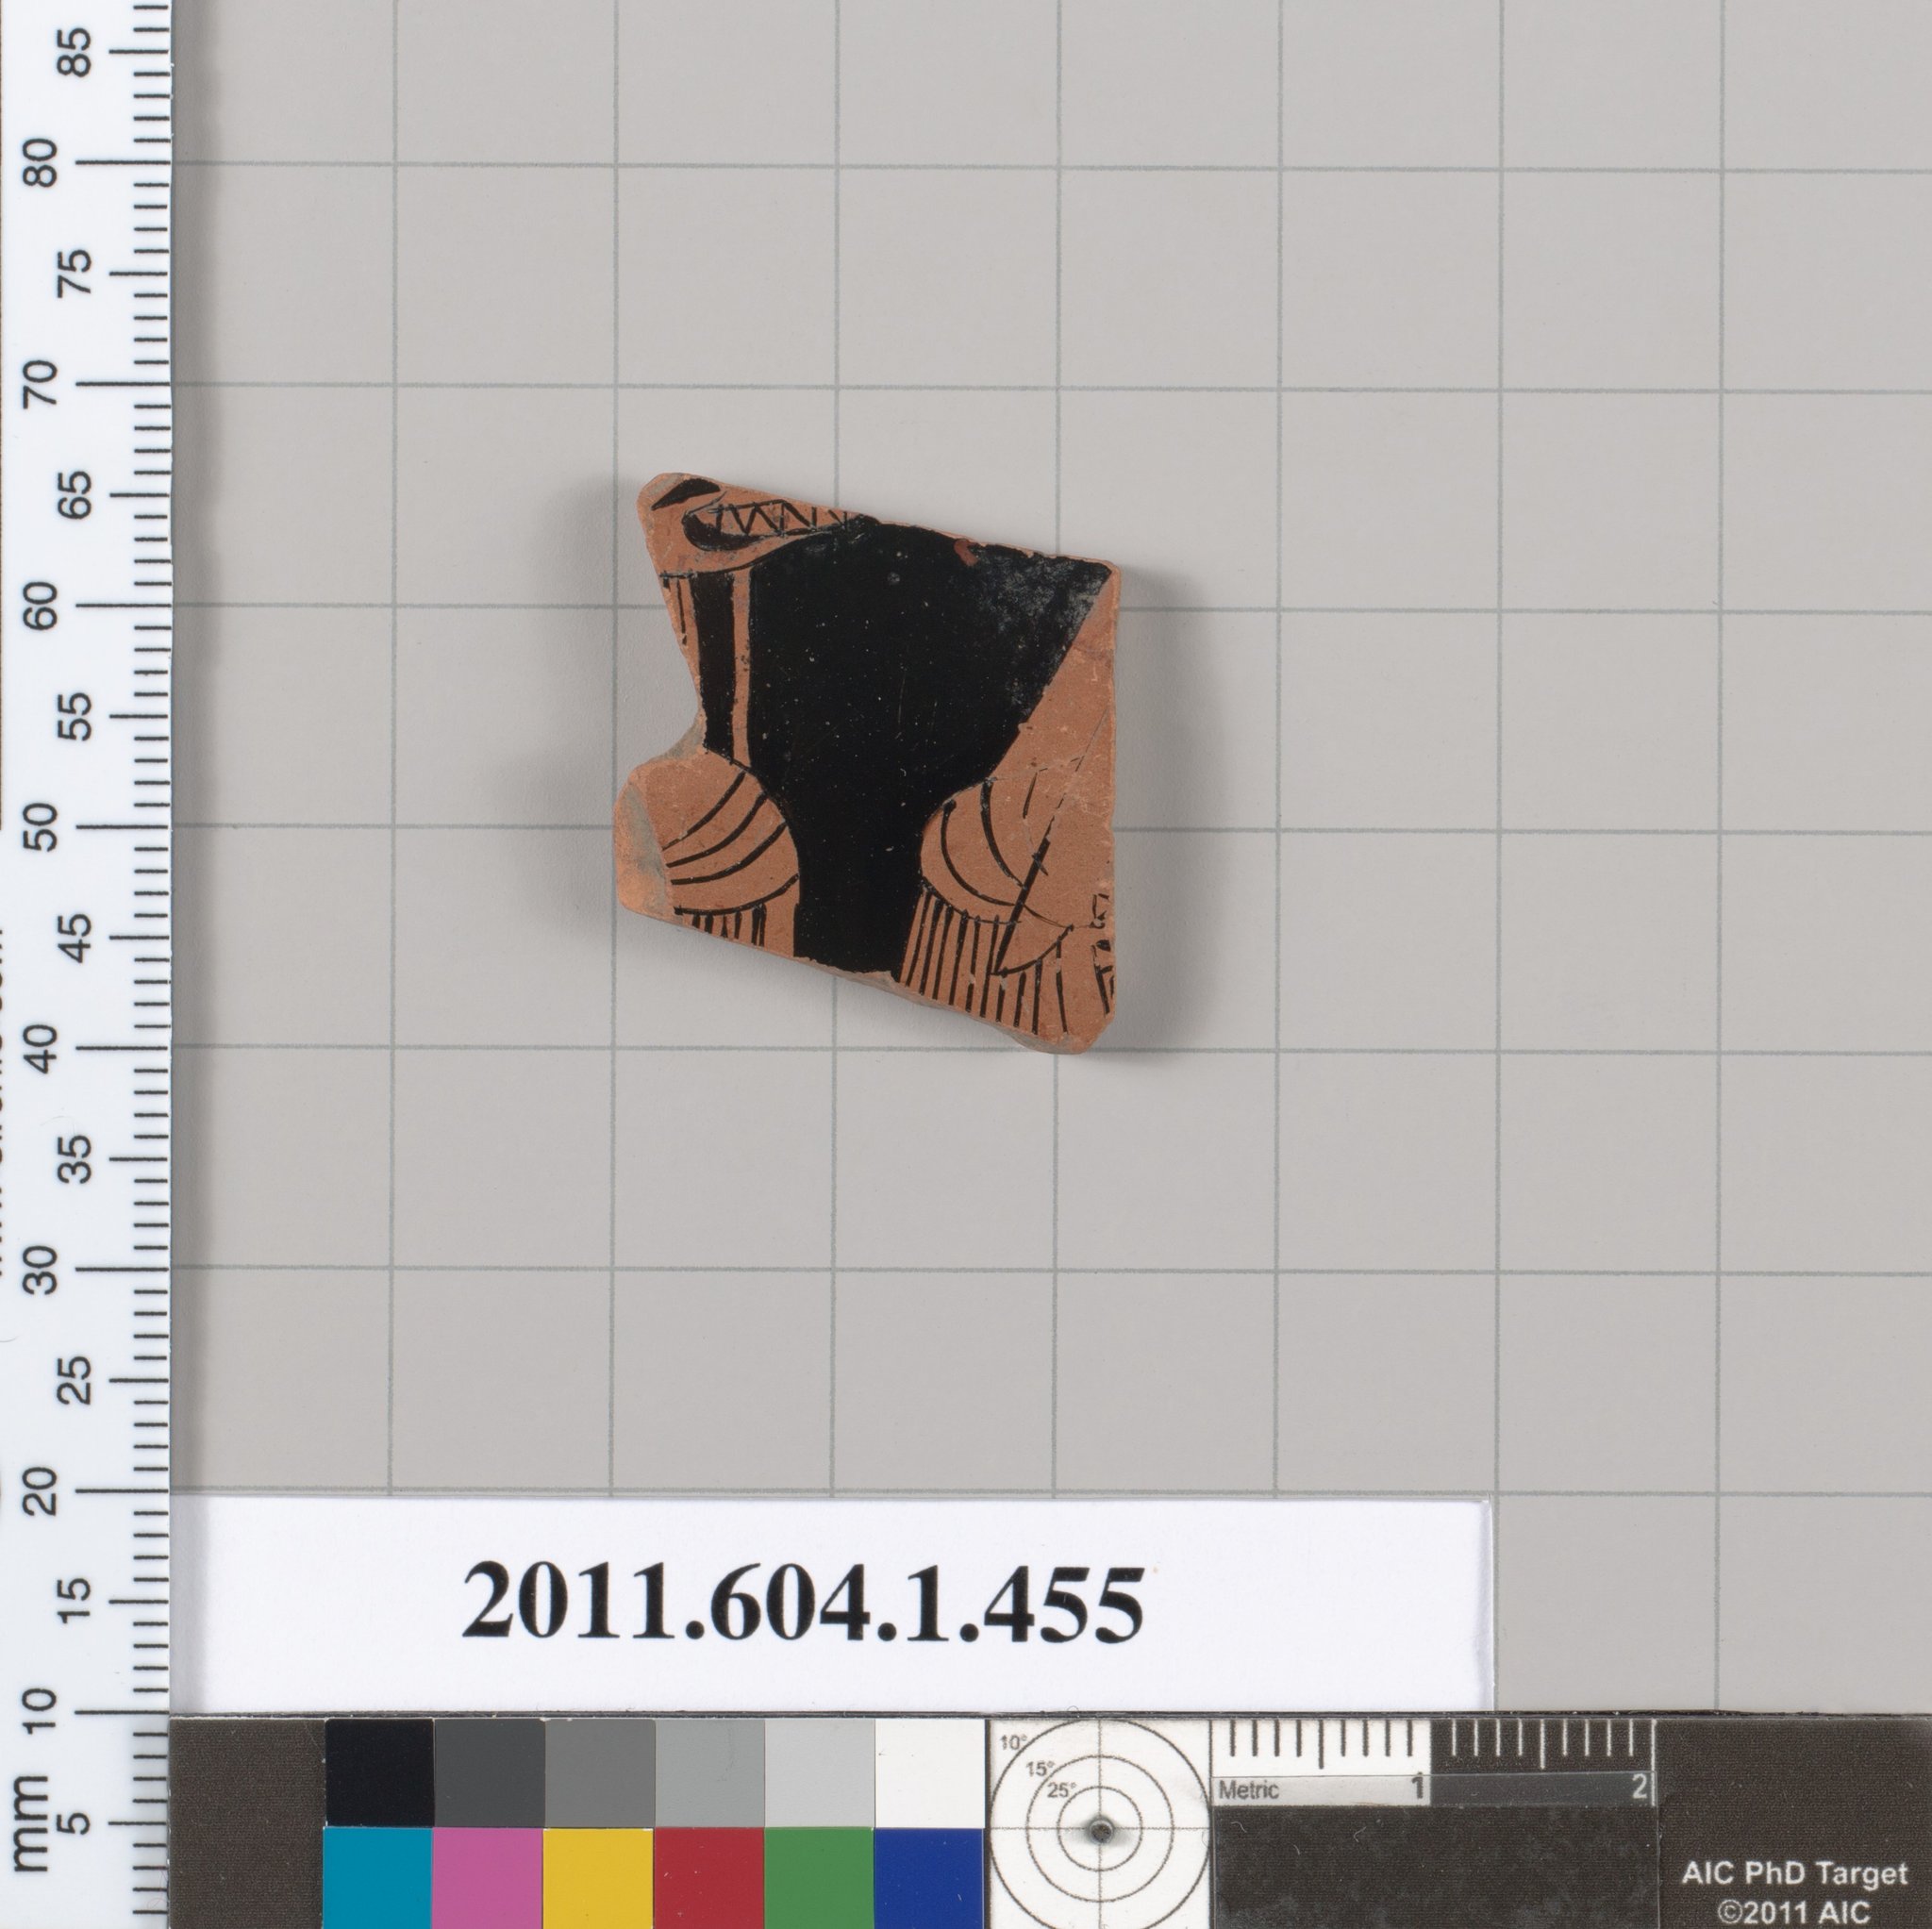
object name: kylix fragment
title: Terracotta fragment of a kylix (drinking cup)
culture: greek, attic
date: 475-451 BCE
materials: terracotta